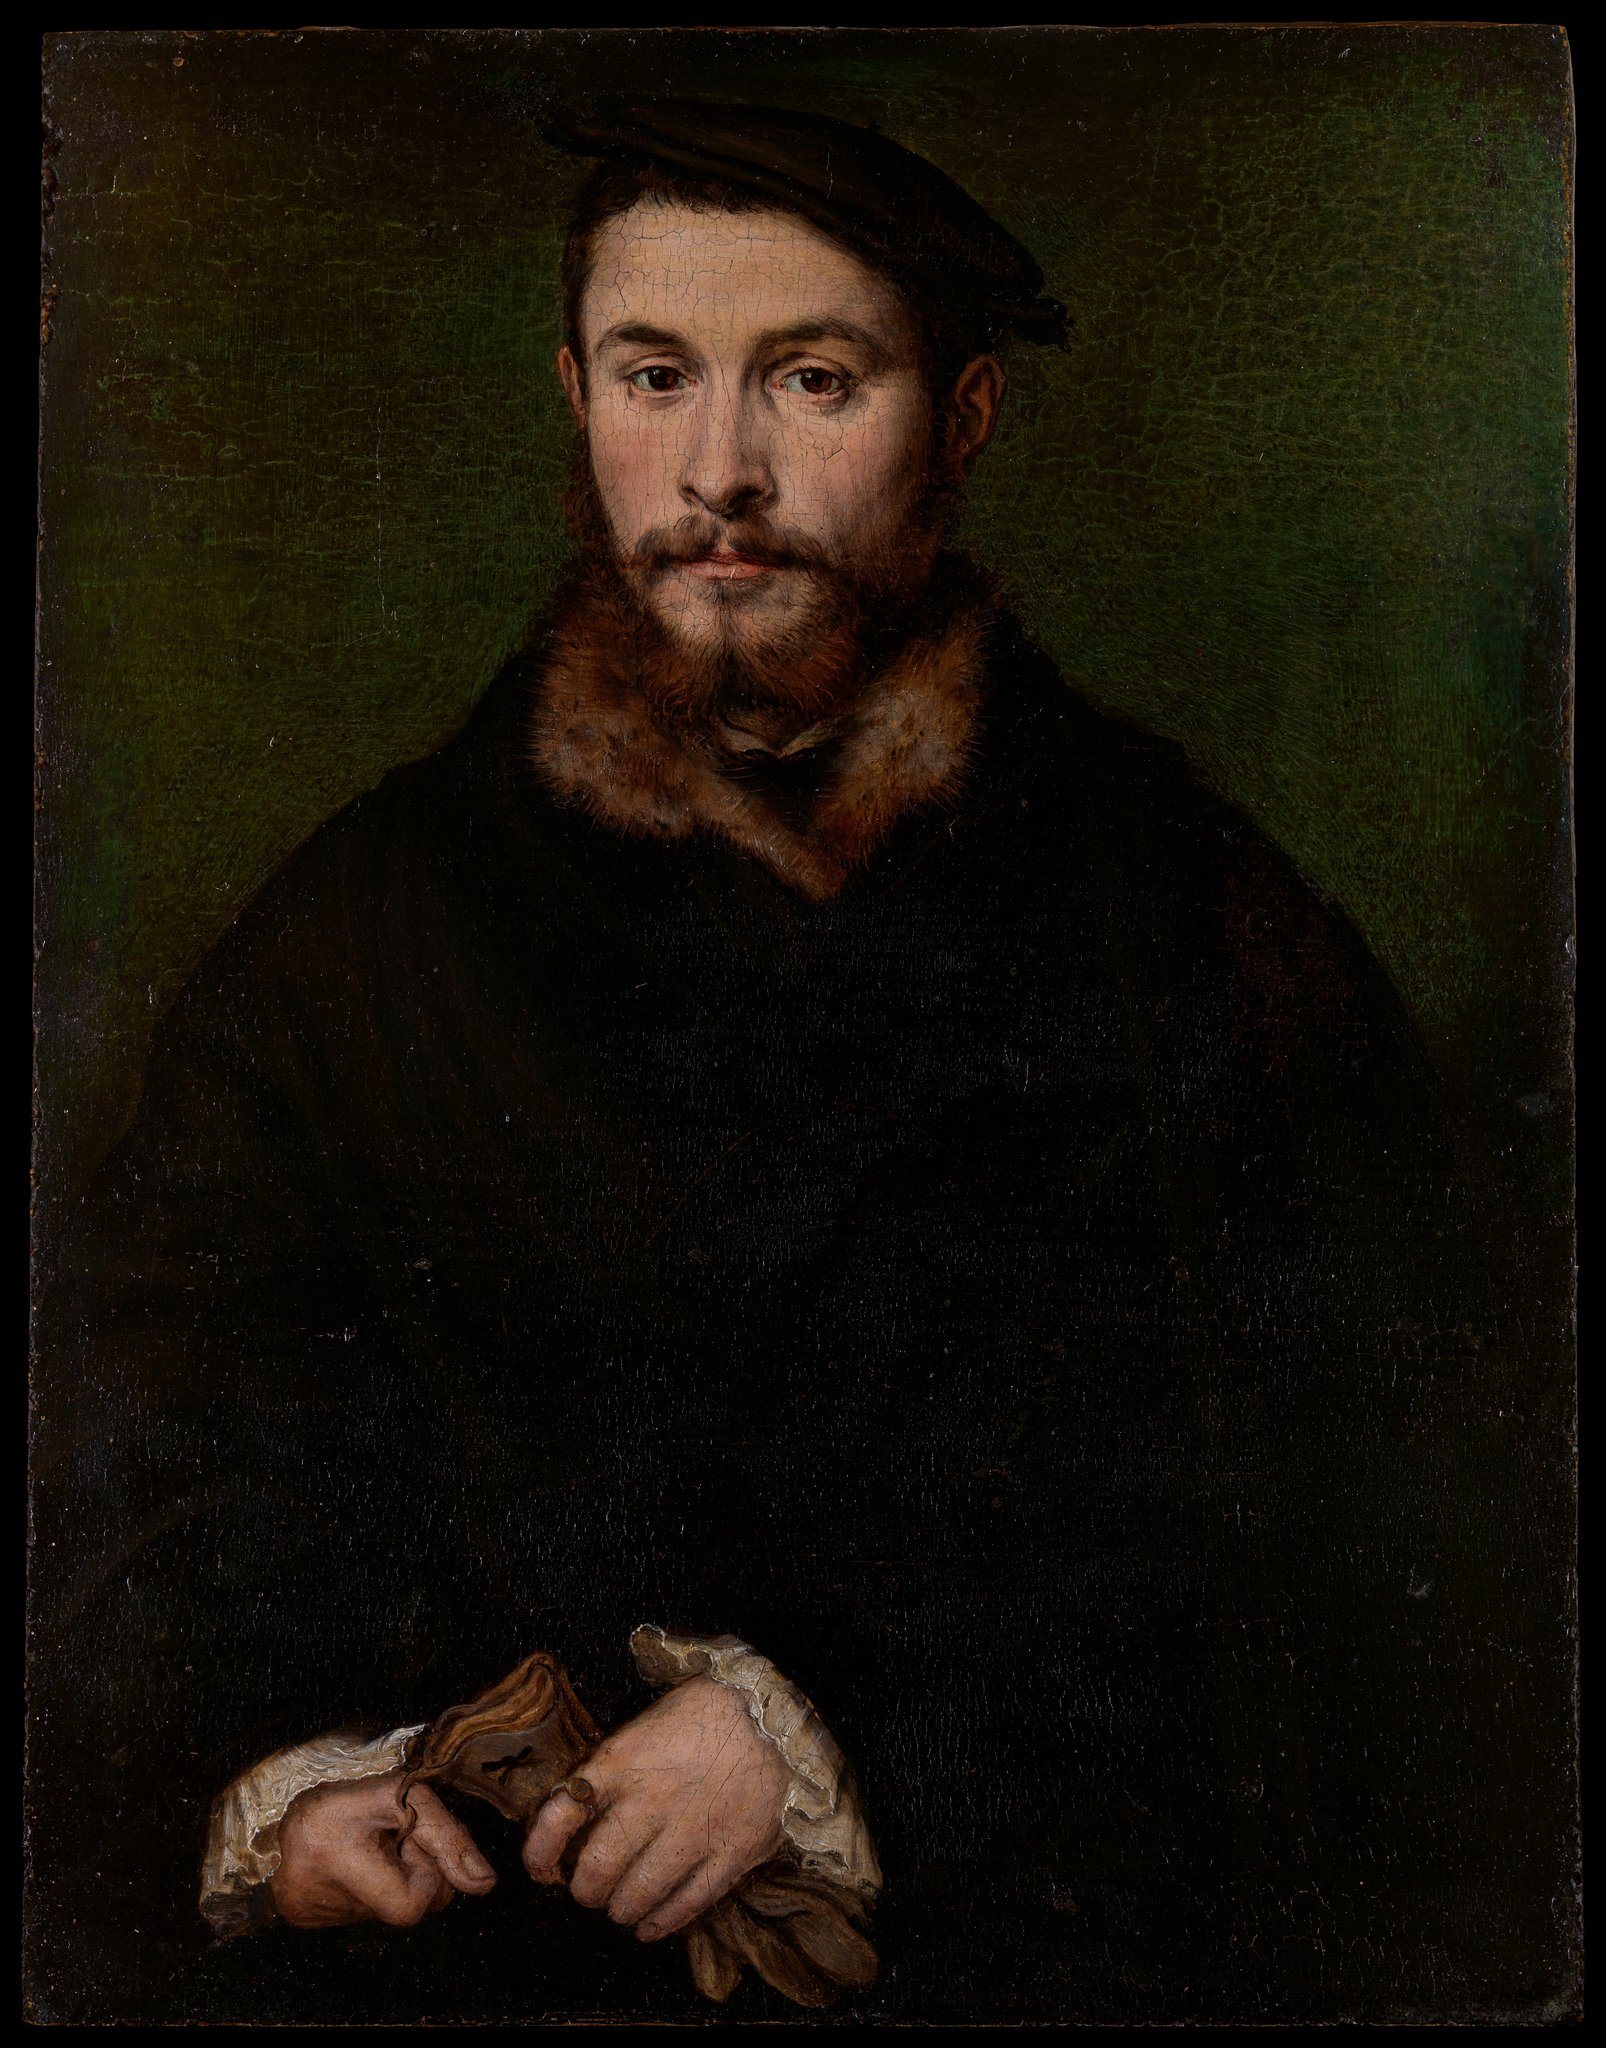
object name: painting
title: Portrait of a Man with Gloves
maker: corneille de lyon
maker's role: artist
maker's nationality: netherlandish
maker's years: 1533-1575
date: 1535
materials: oil, wood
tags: men,portraits